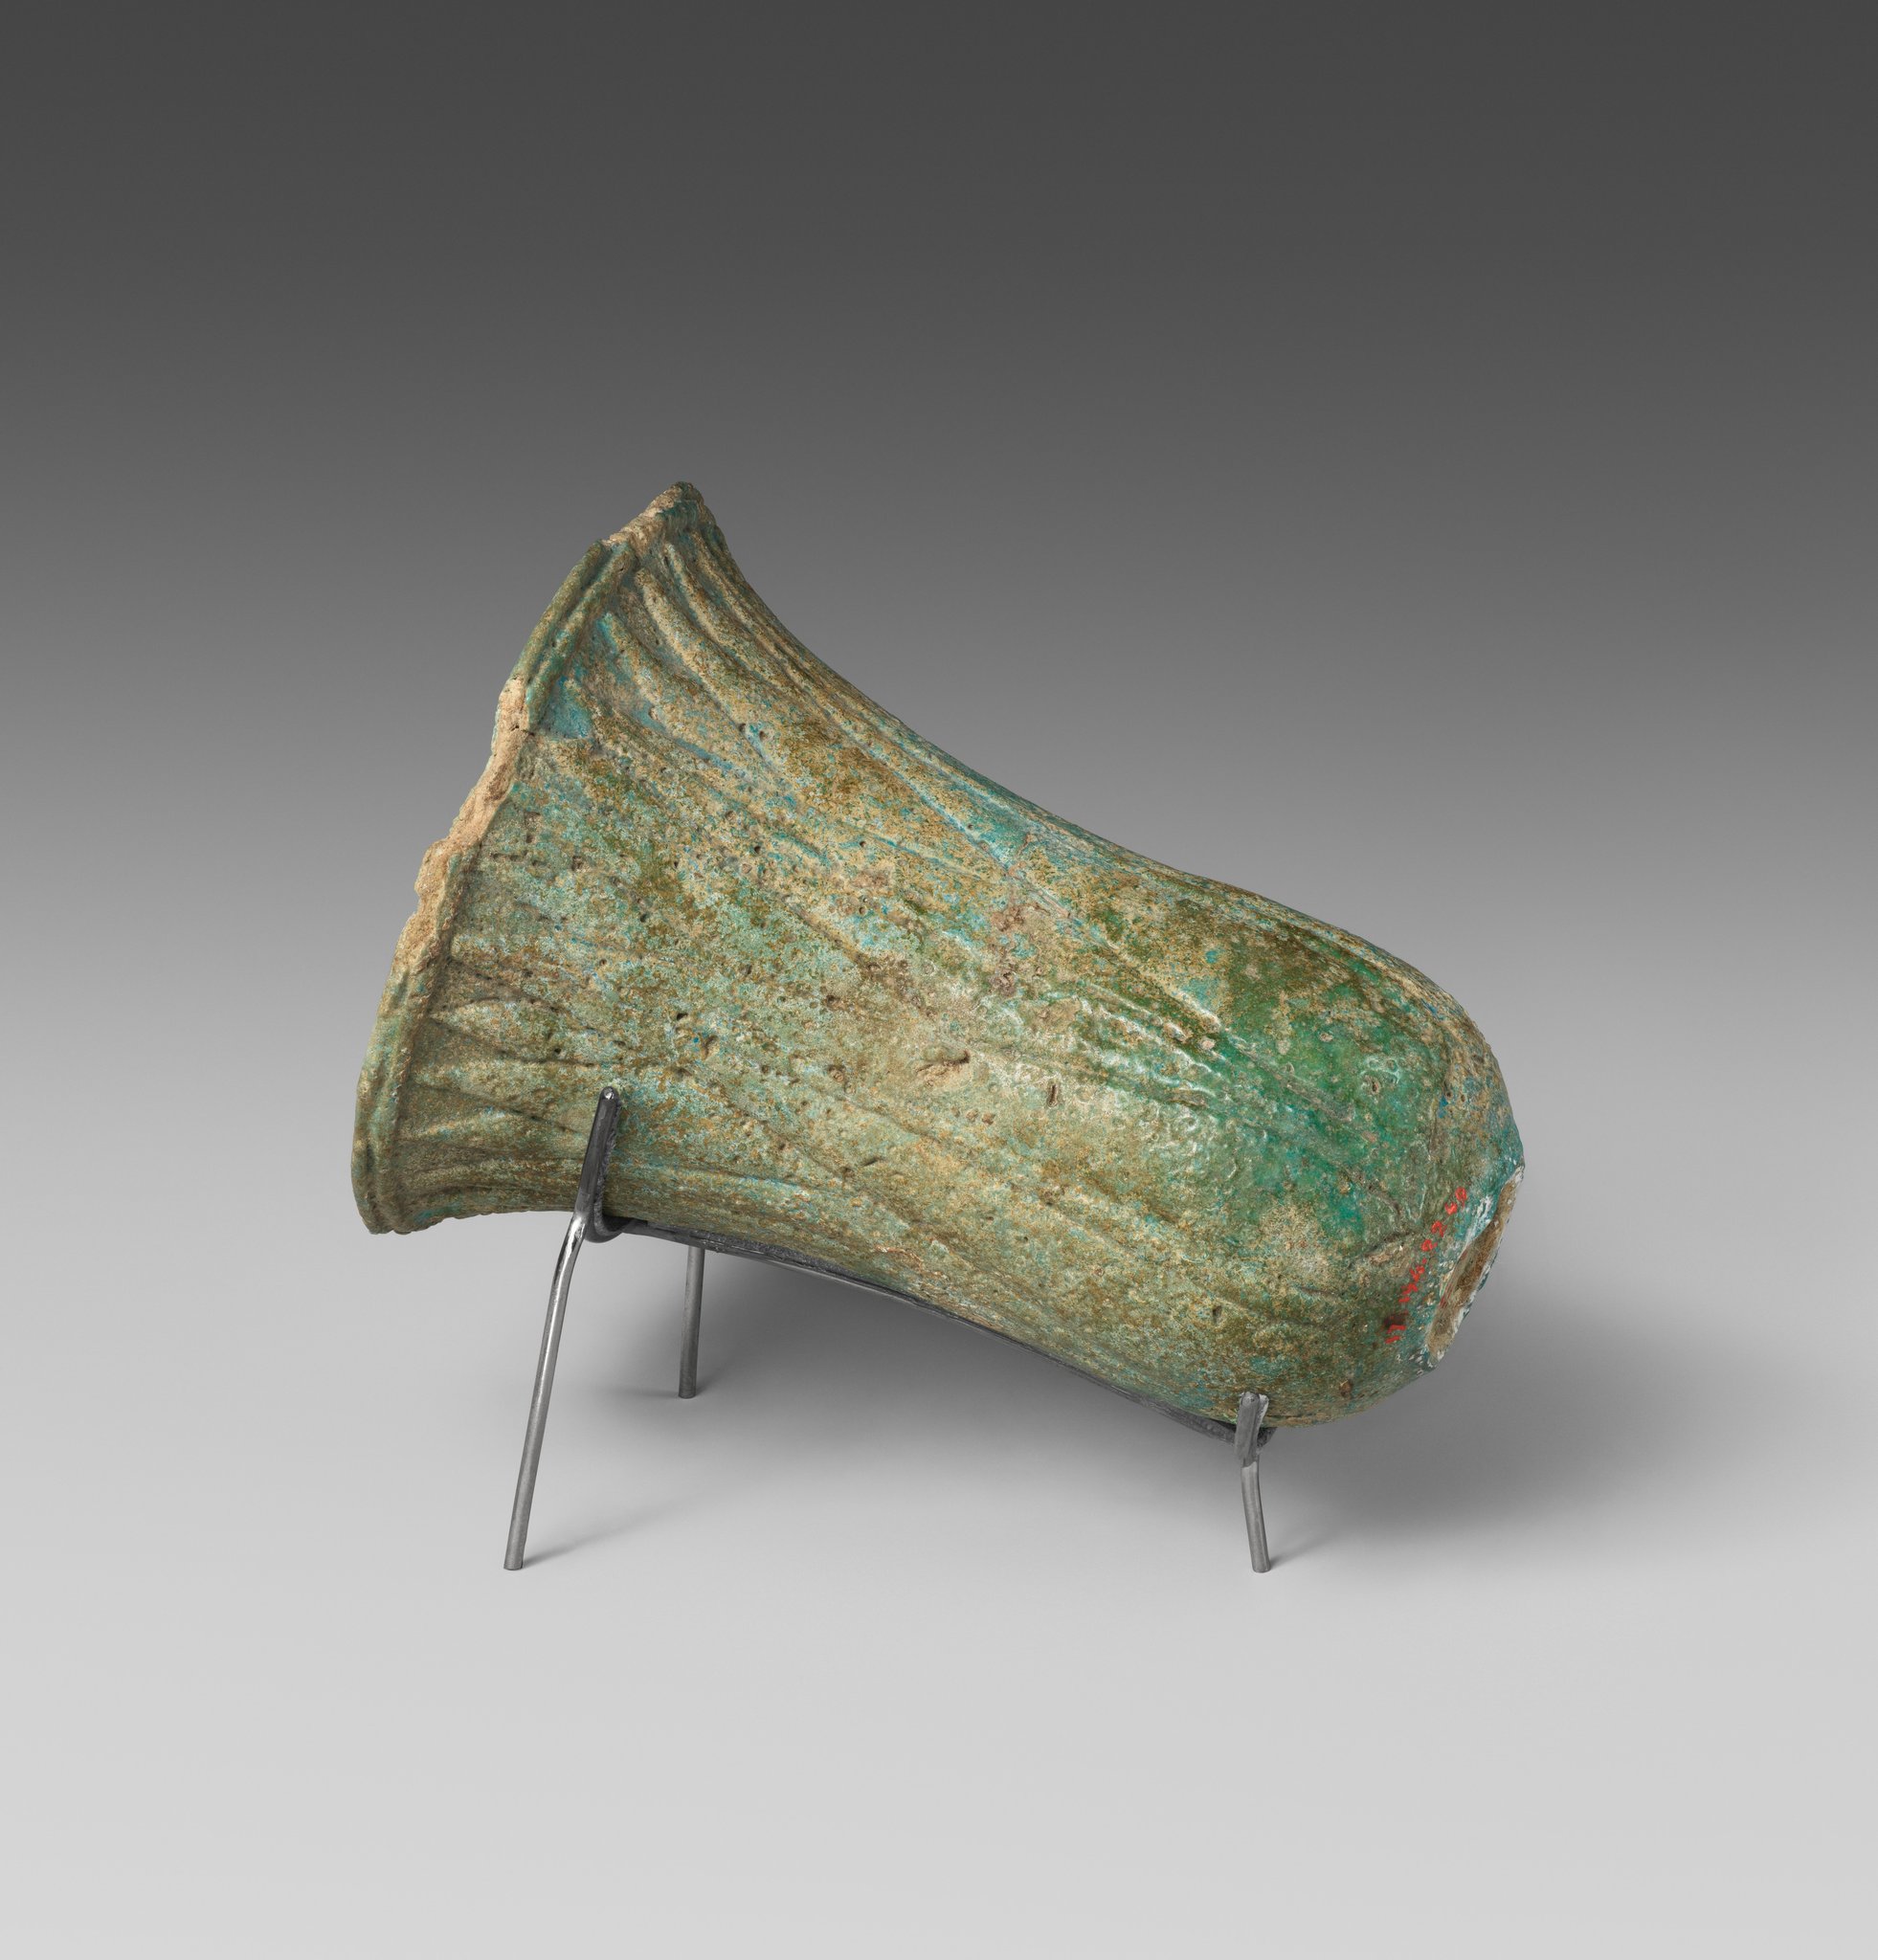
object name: chalice, cup, lotiform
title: Top of Lotiform Cup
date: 1070-664 BCE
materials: faience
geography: egypt